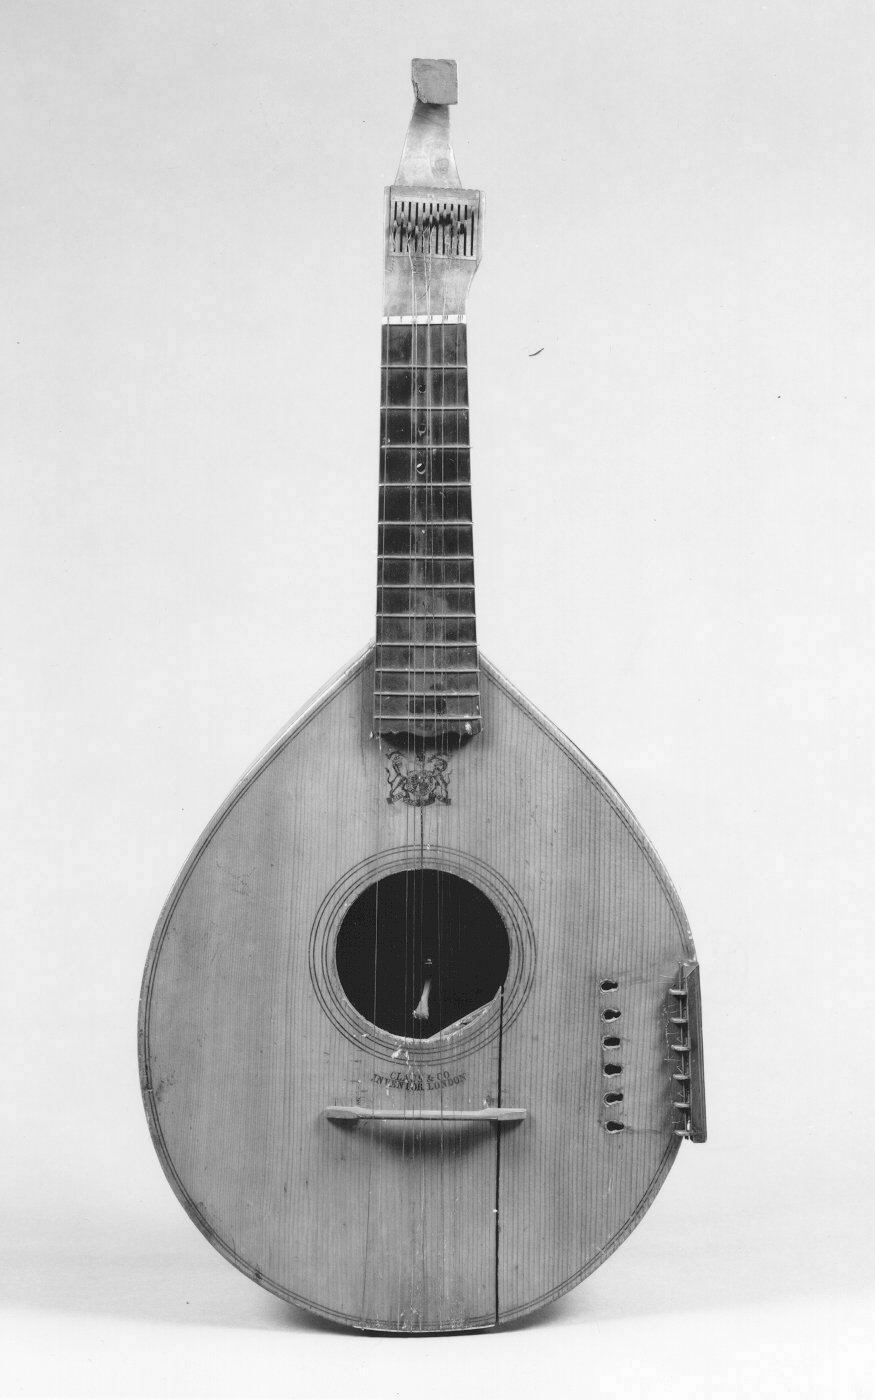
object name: pianoforte guittar keyed cittern english guitar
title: Pianoforte Guittar (Keyed cittern/English Guittar)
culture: british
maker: christian claus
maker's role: maker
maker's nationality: german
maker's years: 1783-1793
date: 1785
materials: bone, brass, ivory, wood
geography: united kingdom